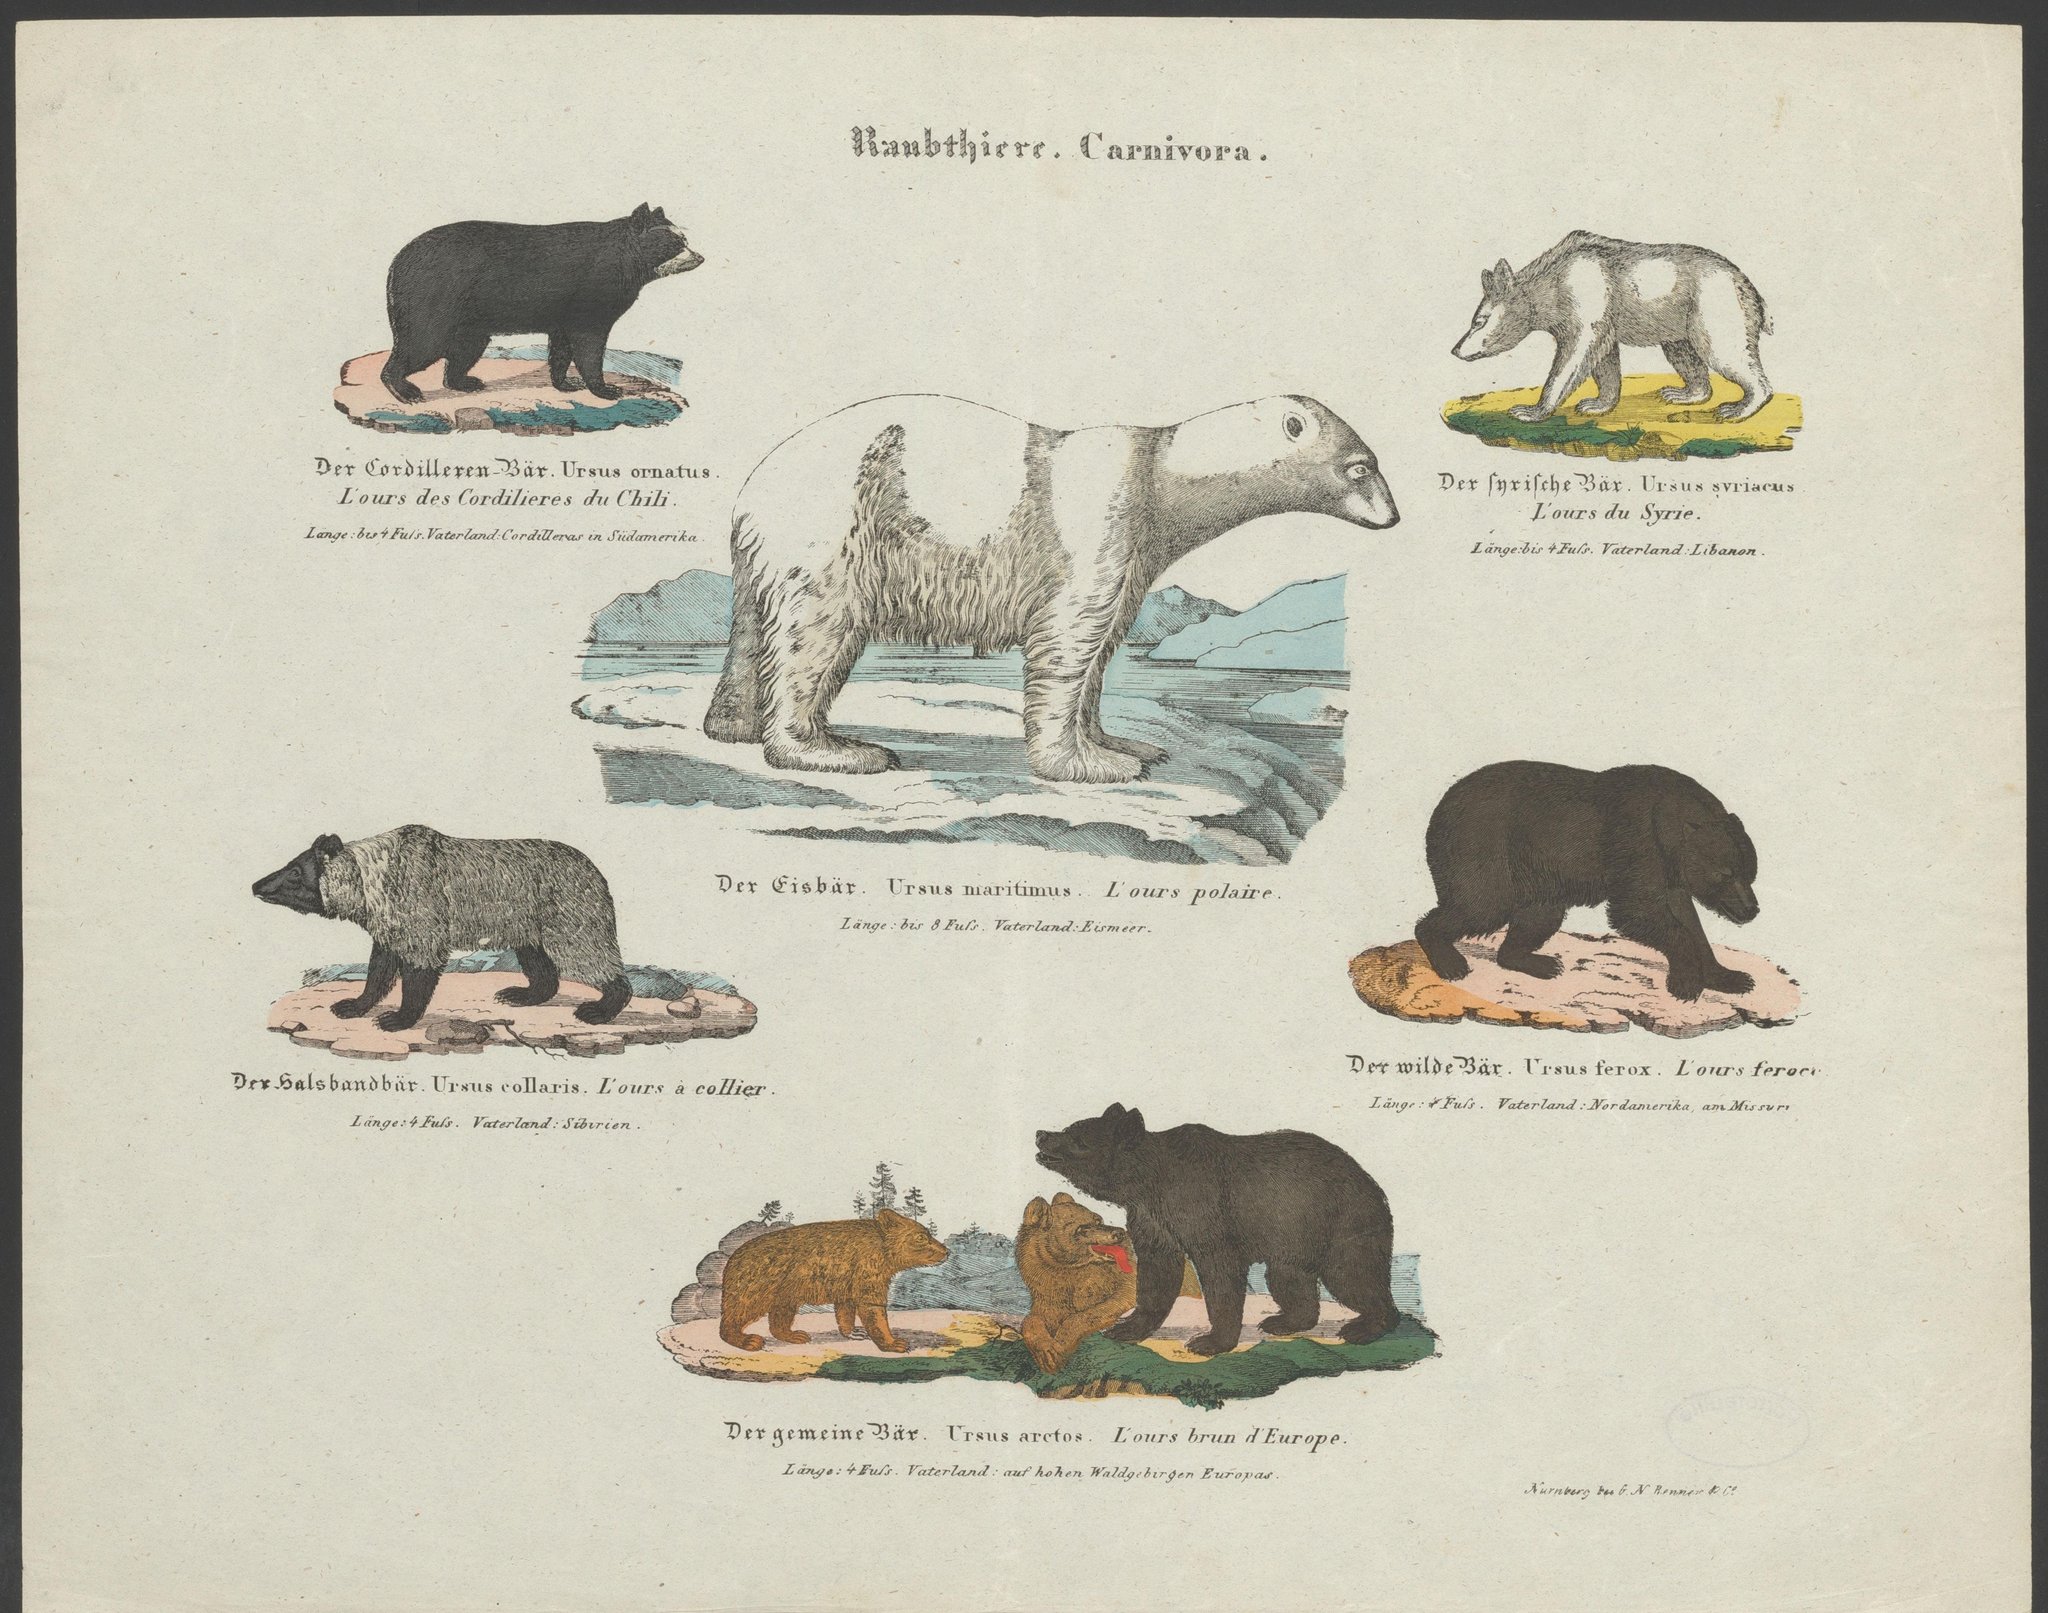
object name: print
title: Raubthiere.Carnivora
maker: Anonymous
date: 1837-1868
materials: paper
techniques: hand coloring, lithograph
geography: nuremberg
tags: beasts of prey, predatory animals: polar bear, beasts of prey, predatory animals: bear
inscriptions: collector's mark: Lugt 1641, stamp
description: Zes voorstellingen van diverse soorten beren. In het midden een ijsbeer. Onder iedere voorstelling de naam van het soort in het Duits, Latijn en Frans. Daaronder de afmeting en land van herkomst van het dier. Onderwerpsrubrieken binnen de Atlas Zeden en Gewoonten: Zeden en Gewoonten in Engeren Zin, Des menschen beging, midden en einde, Kinderleven – Kinderspel en Kinderprenten.